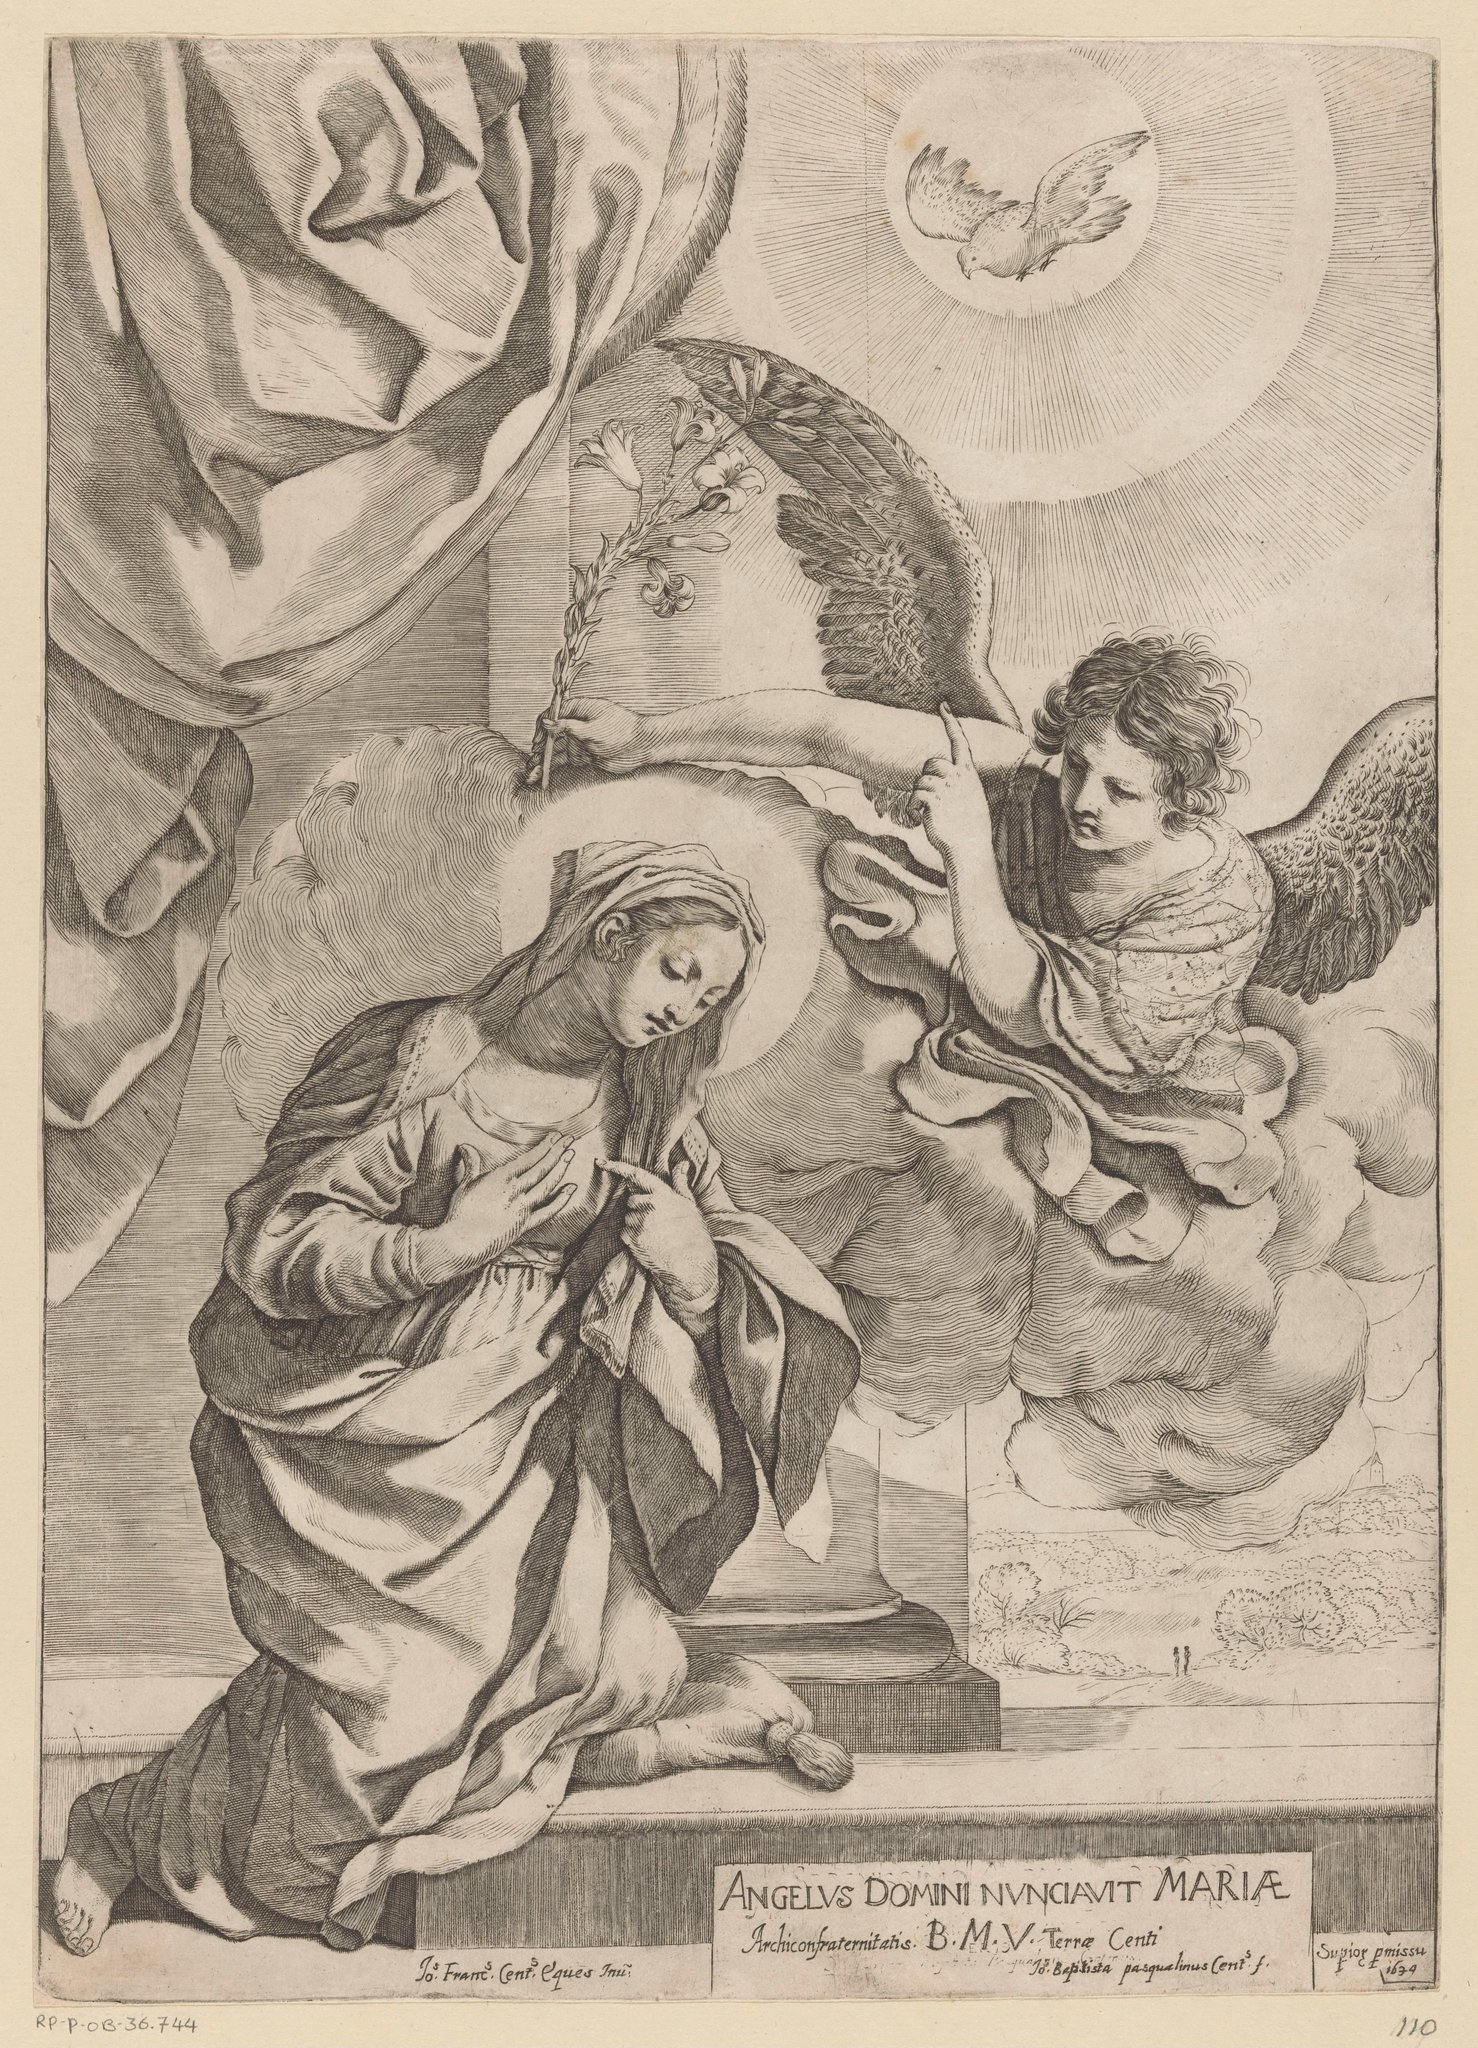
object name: print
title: Annunciatie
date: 1629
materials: paper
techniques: engraving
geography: vatican city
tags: the annunciation: mary kneeling - aa - mary to the left, the angel to the right, flowers: lily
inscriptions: collector's mark: Lugt 240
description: De engel Gabriël met een tak met lelies in de hand verschijnt aan Maria en kondigt haar zwangerschap aan. Rechtsboven de Heilige Geest als duif.